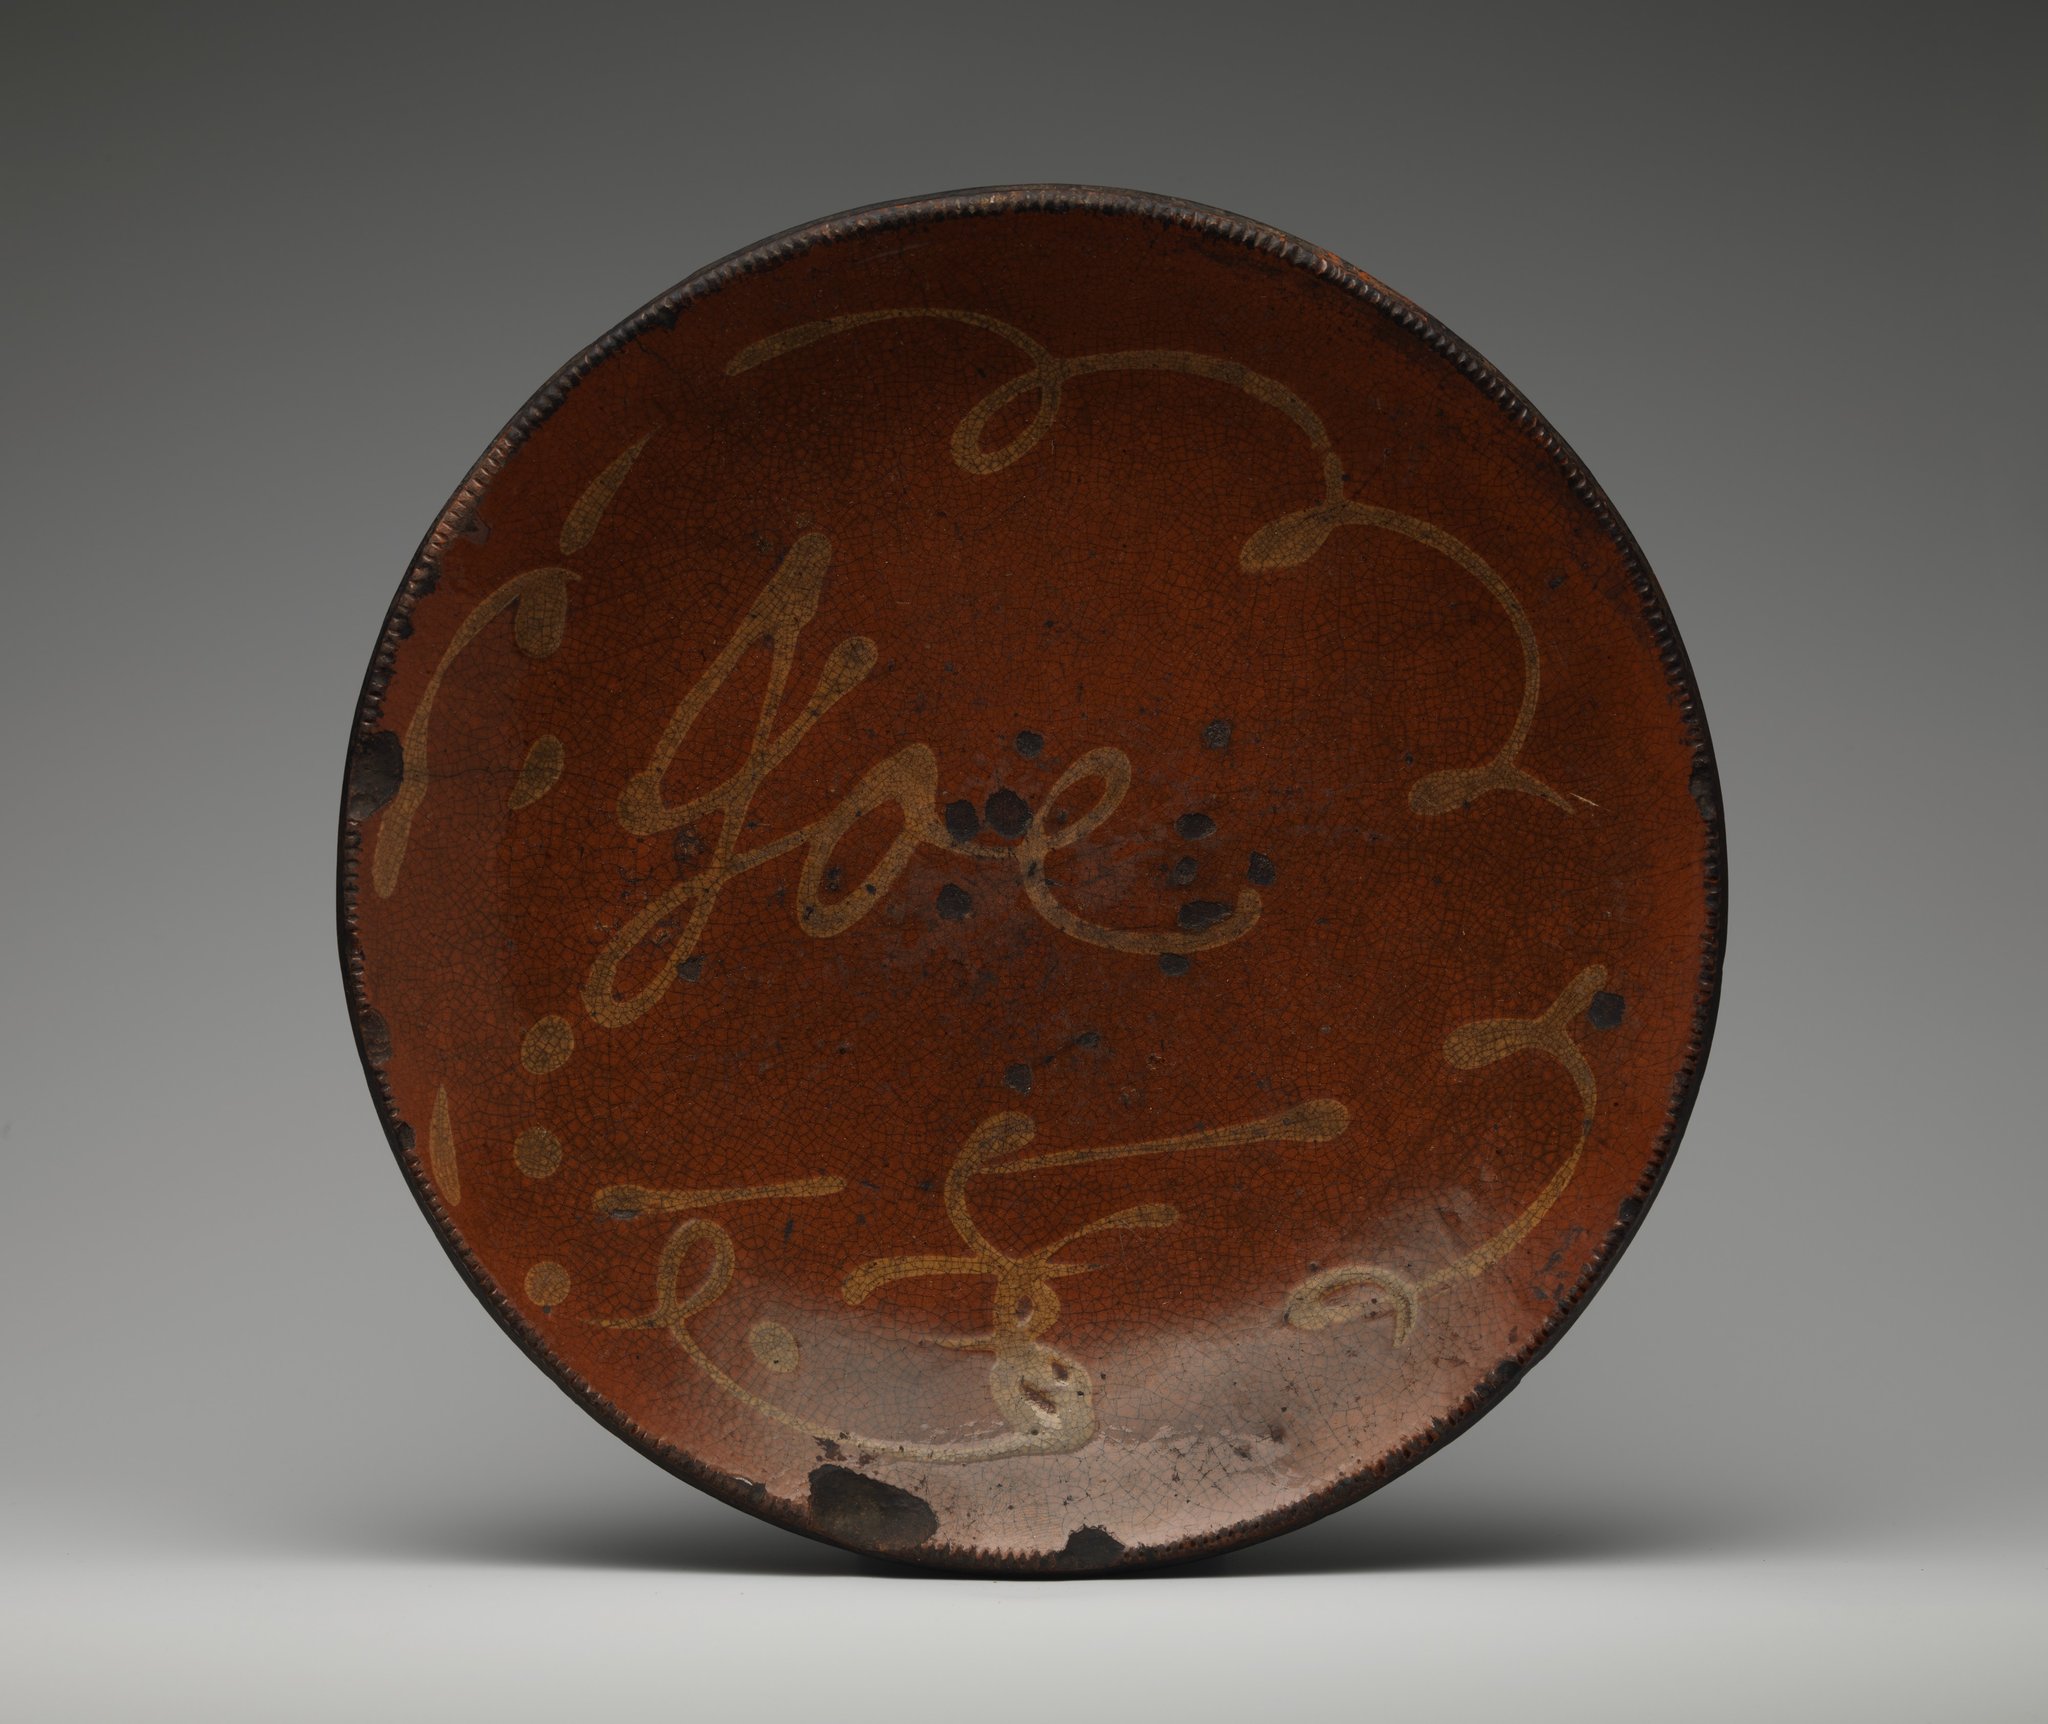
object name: plate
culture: american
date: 1770-1830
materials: earthenware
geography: united states